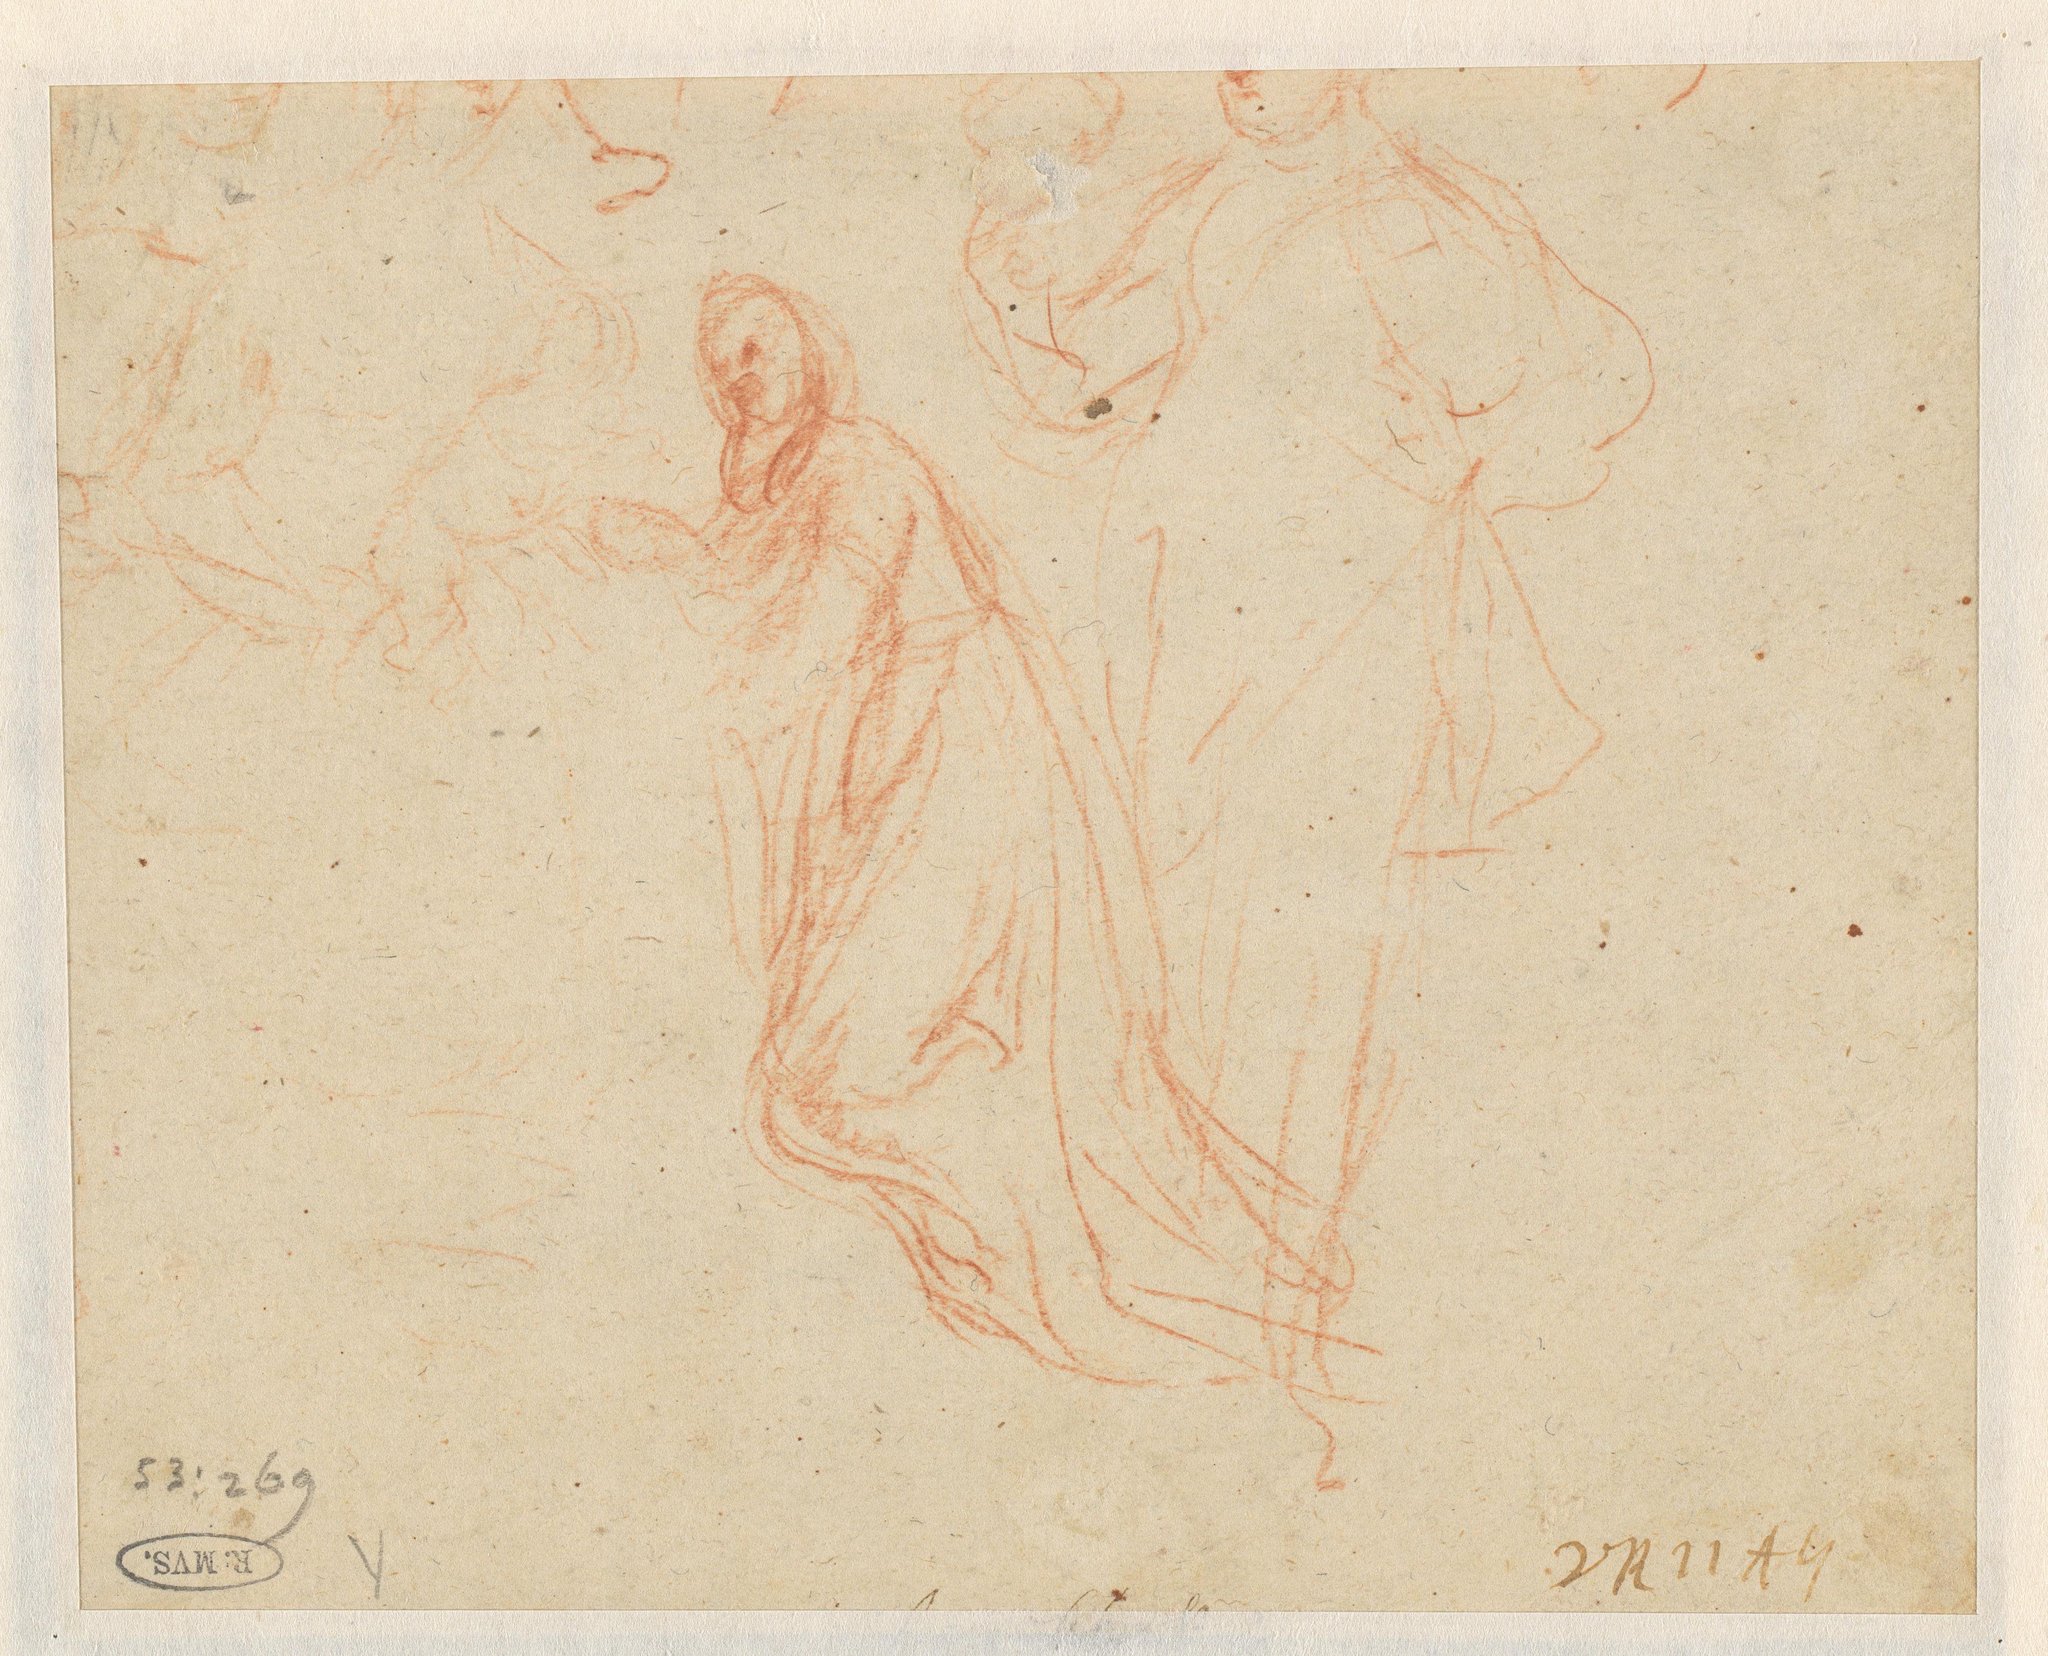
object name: drawing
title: Studieblad met knielende en staande figuren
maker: jan gerritsz. van bronckhorst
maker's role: draughtsman, painter, print maker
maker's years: 1603-1661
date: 1613-1677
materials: chalk, paper